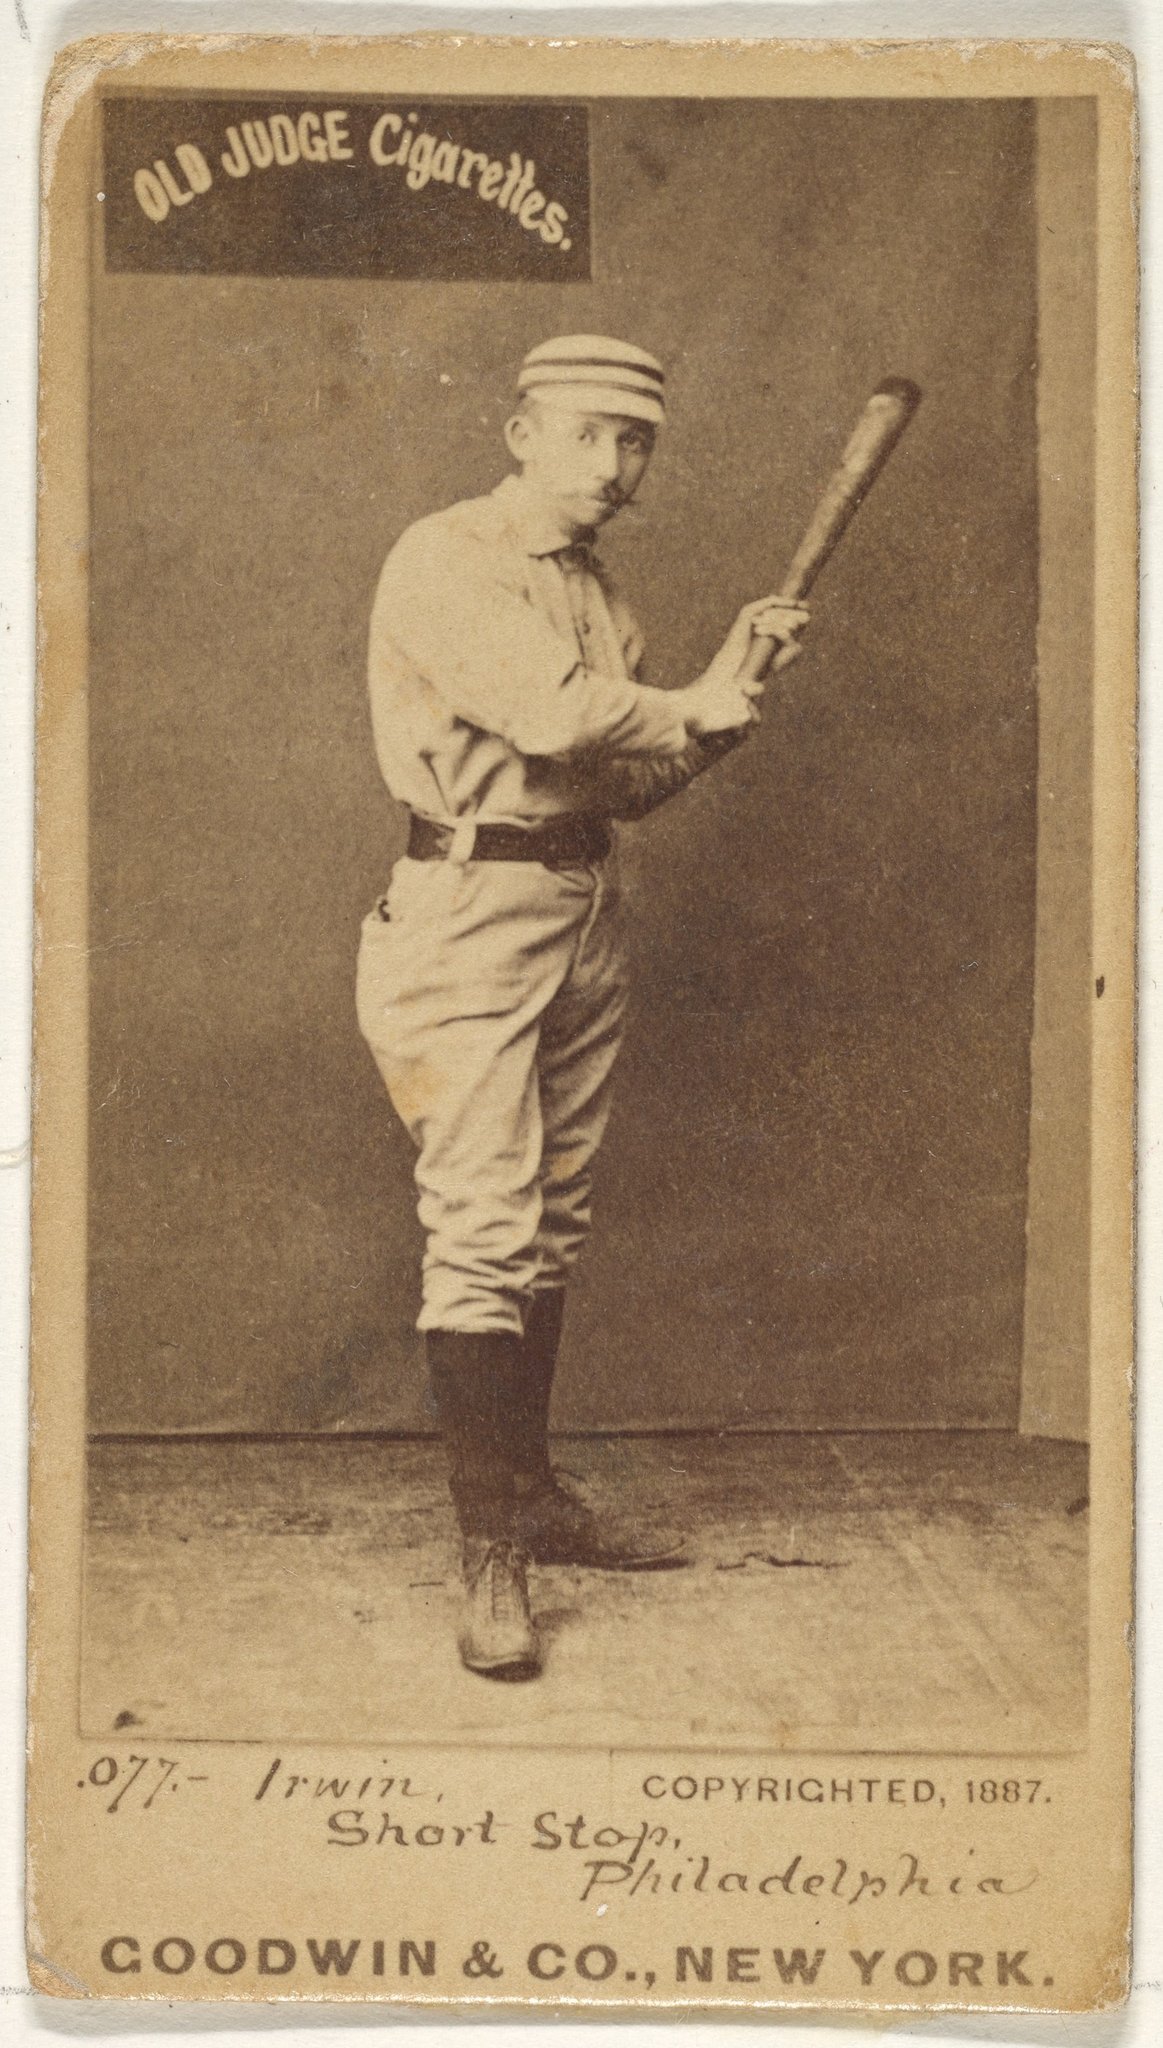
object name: baseball card, photograph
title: Arthur Albert "Doc" Irwin, Shortstop, Philadelphia, from the Old Judge series (N172) for Old Judge Cigarettes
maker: goodwin & company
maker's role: publisher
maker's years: 1850-1950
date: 1887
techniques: albumen silver print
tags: men,portraits,baseball,athletes